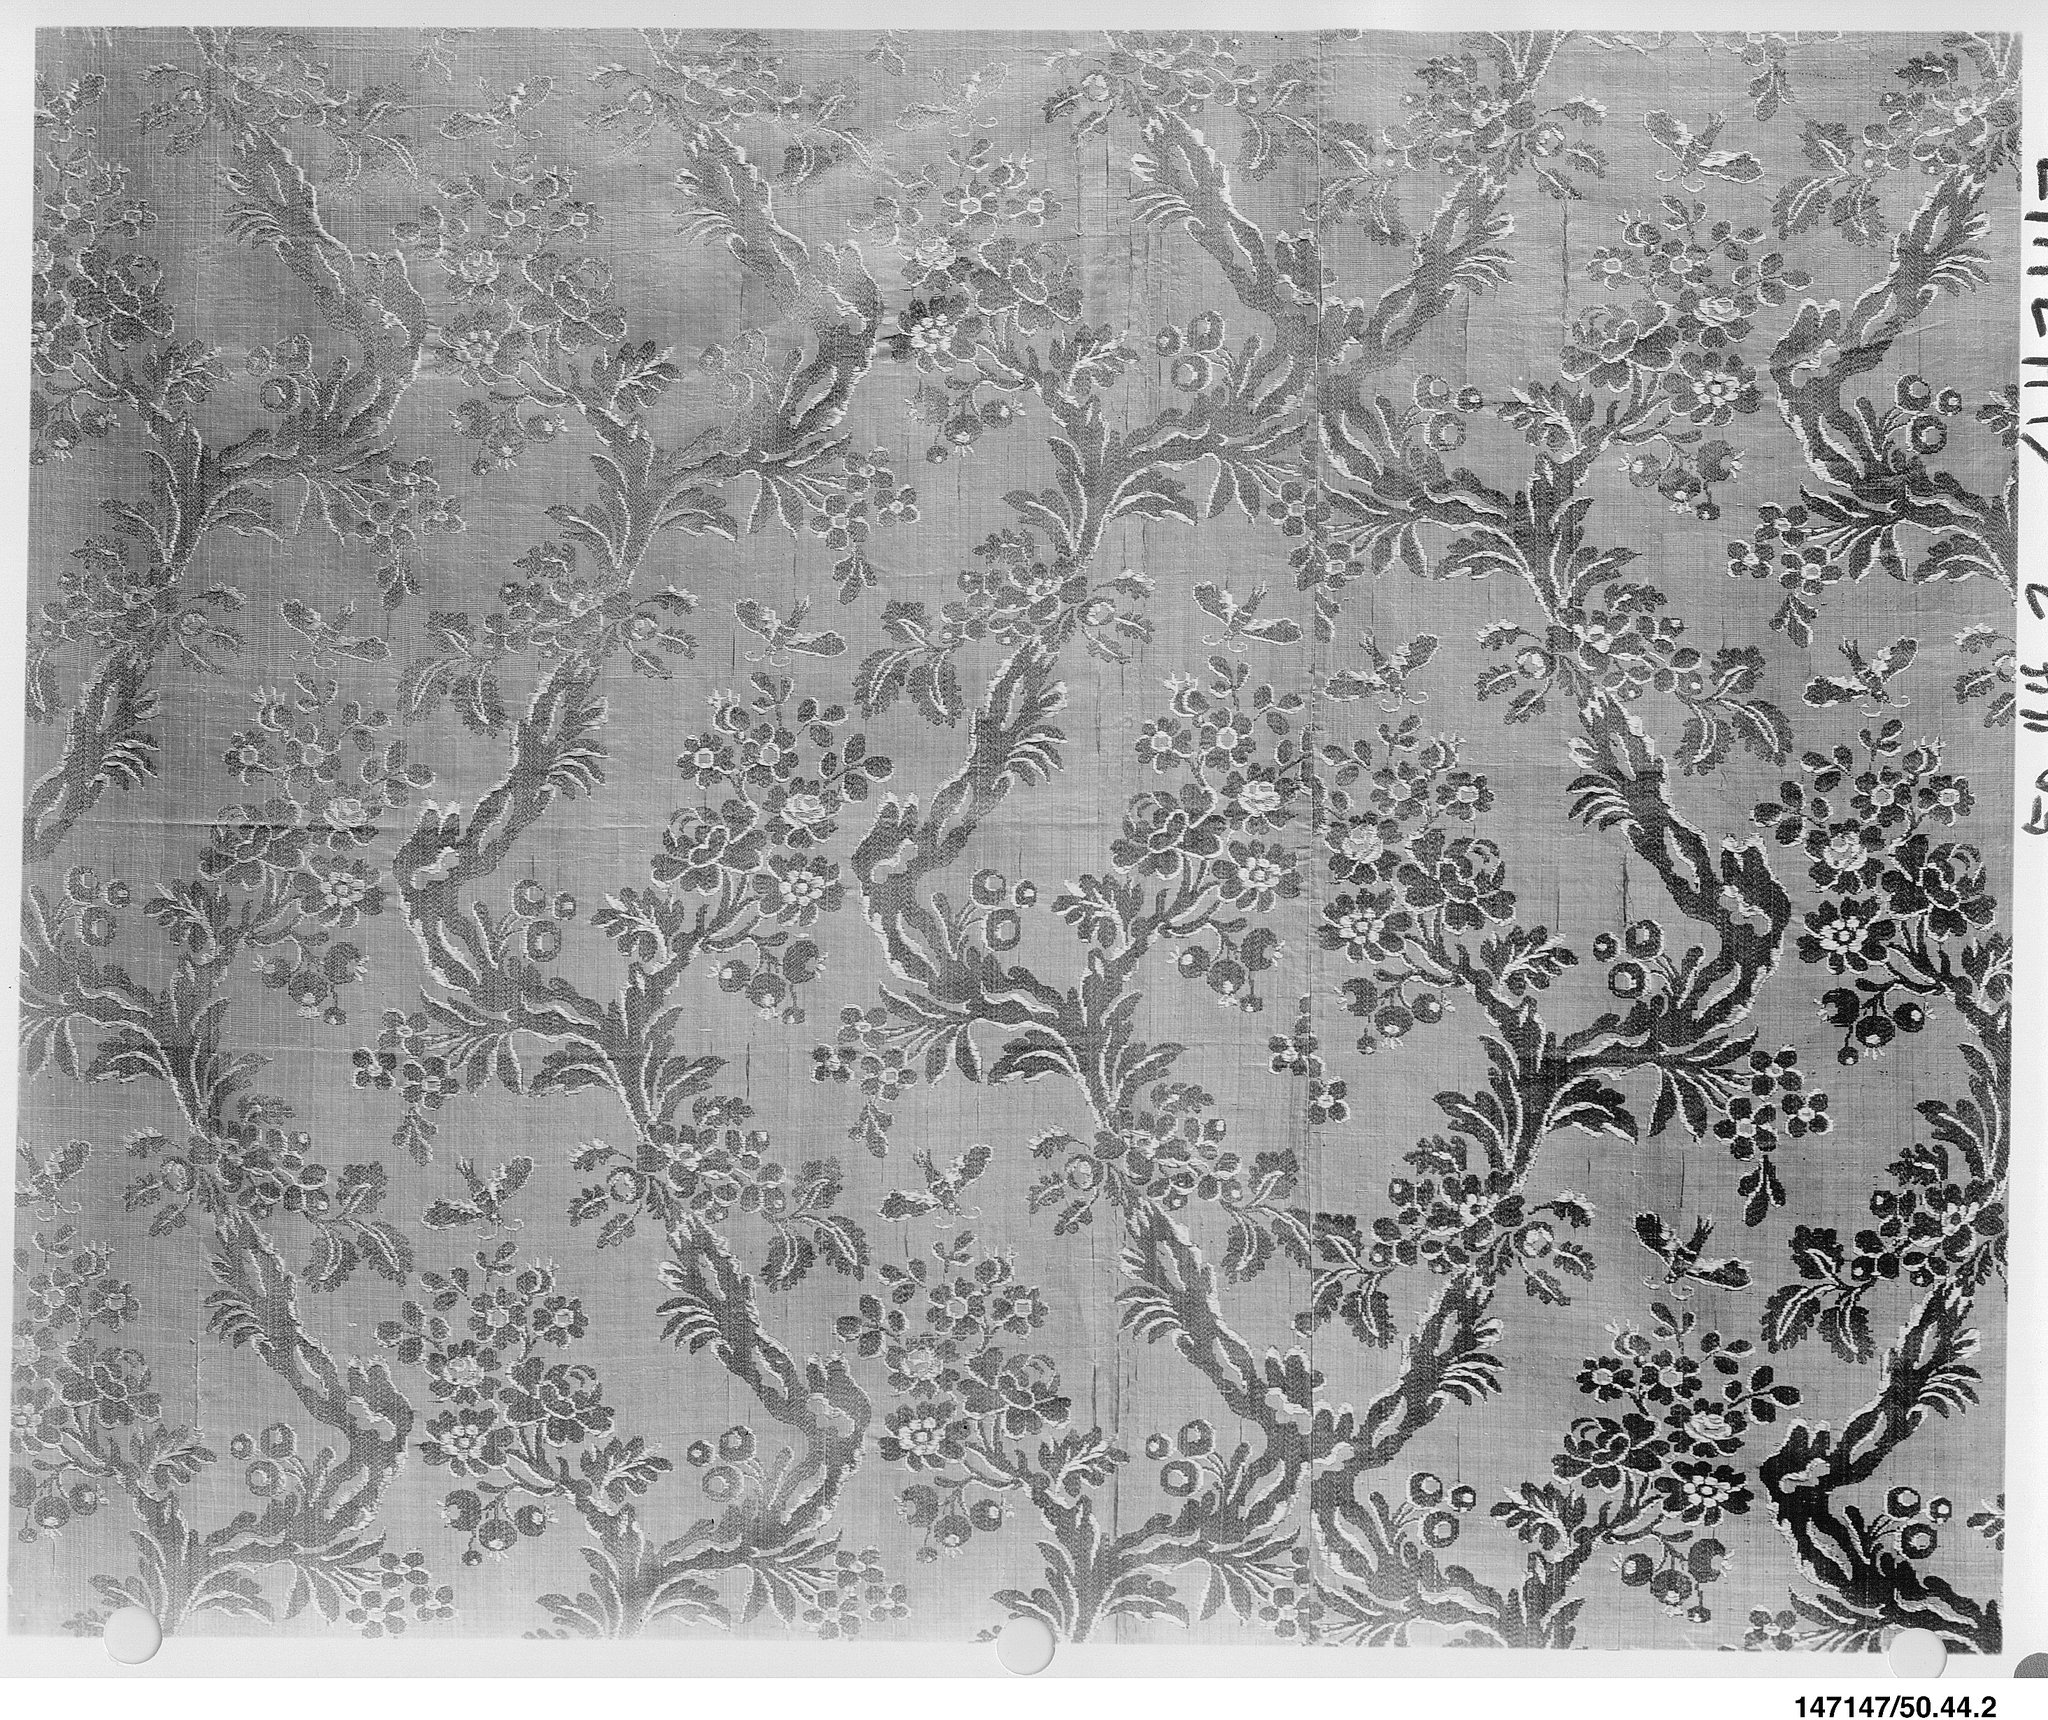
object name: piece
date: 1760-1770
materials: silk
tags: flowers,leaves